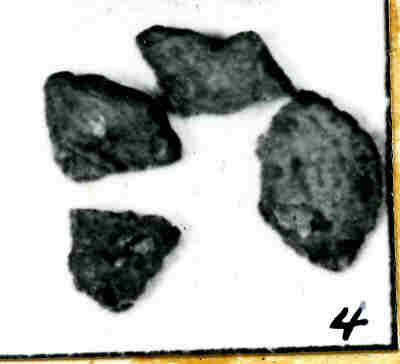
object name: coin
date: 701-900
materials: copper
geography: iran